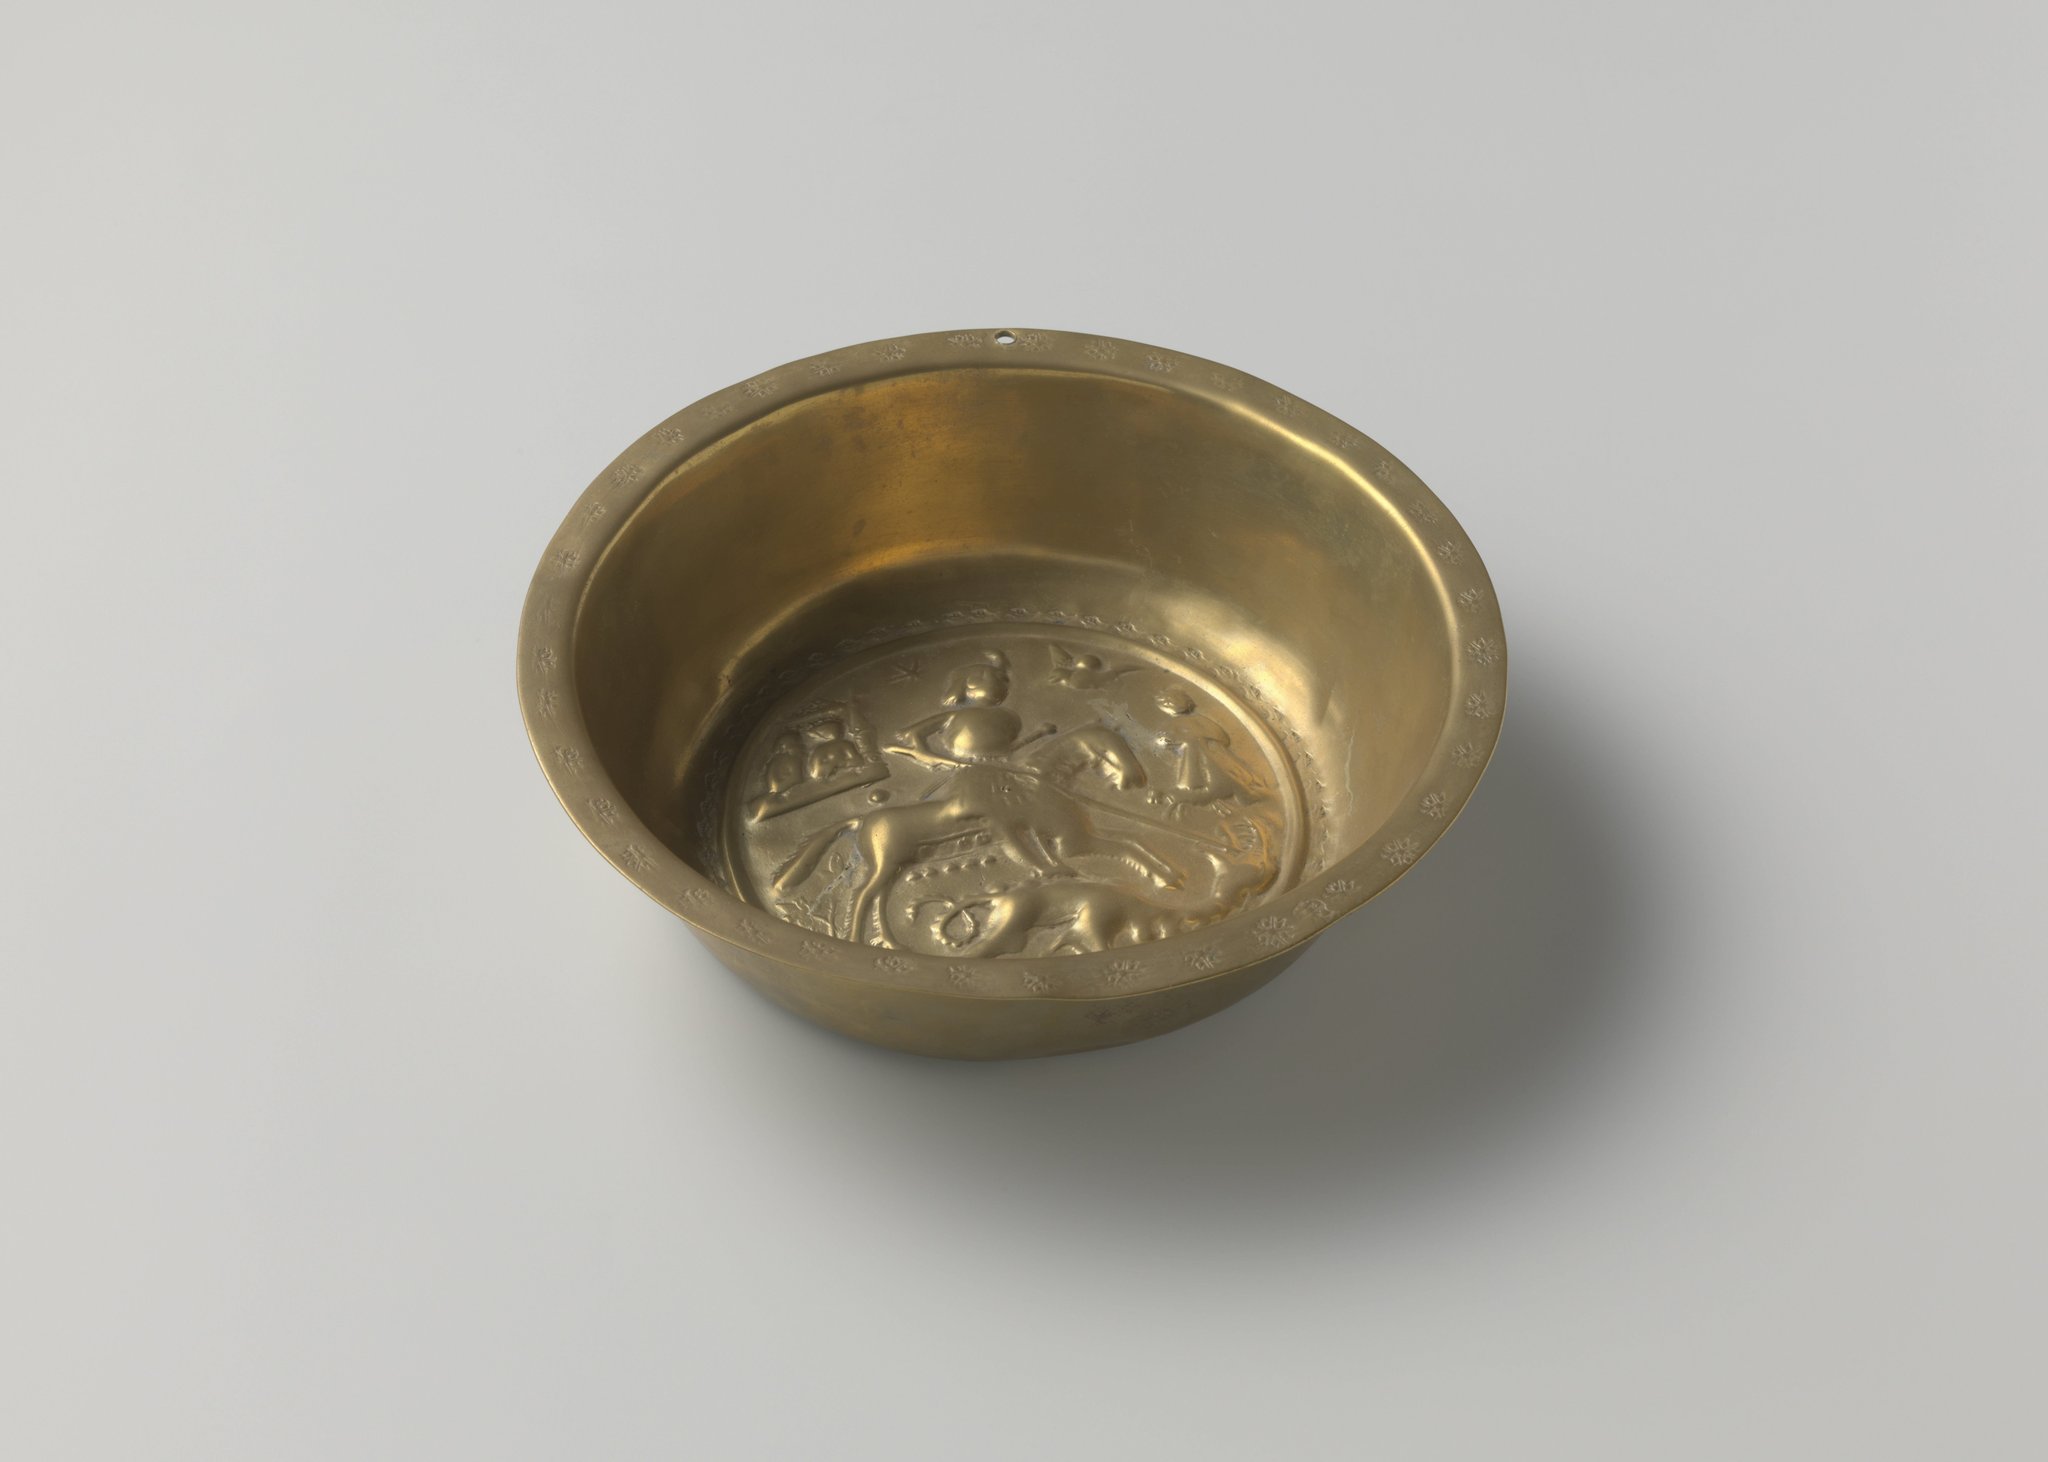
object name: bekken schaal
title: Bekken met de heilige Joris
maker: Anonymous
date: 1500-1600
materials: brass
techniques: casting, metalworking, punching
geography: nuremberg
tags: the warrior martyr george (georgius); possible attributes: banner (red cross on white field), (red) cross, dragon, (white) horse, broken lance, shield (with cross), sword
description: In het plat van het bekken is met behulp van een stempelvorm een aan de Legenda Aurea ontleende voorstelling geponst van de H. Joris in gevecht met de draak met op de achtergrond de prinses, het koningspaar en de engel. Deze is omgeven door een geponste rand van gestileerd bladornament. Op de boord is een rand van rozetten geponst. De hangring aan de achterzijde en het gat in de rand zijn later aangebracht.